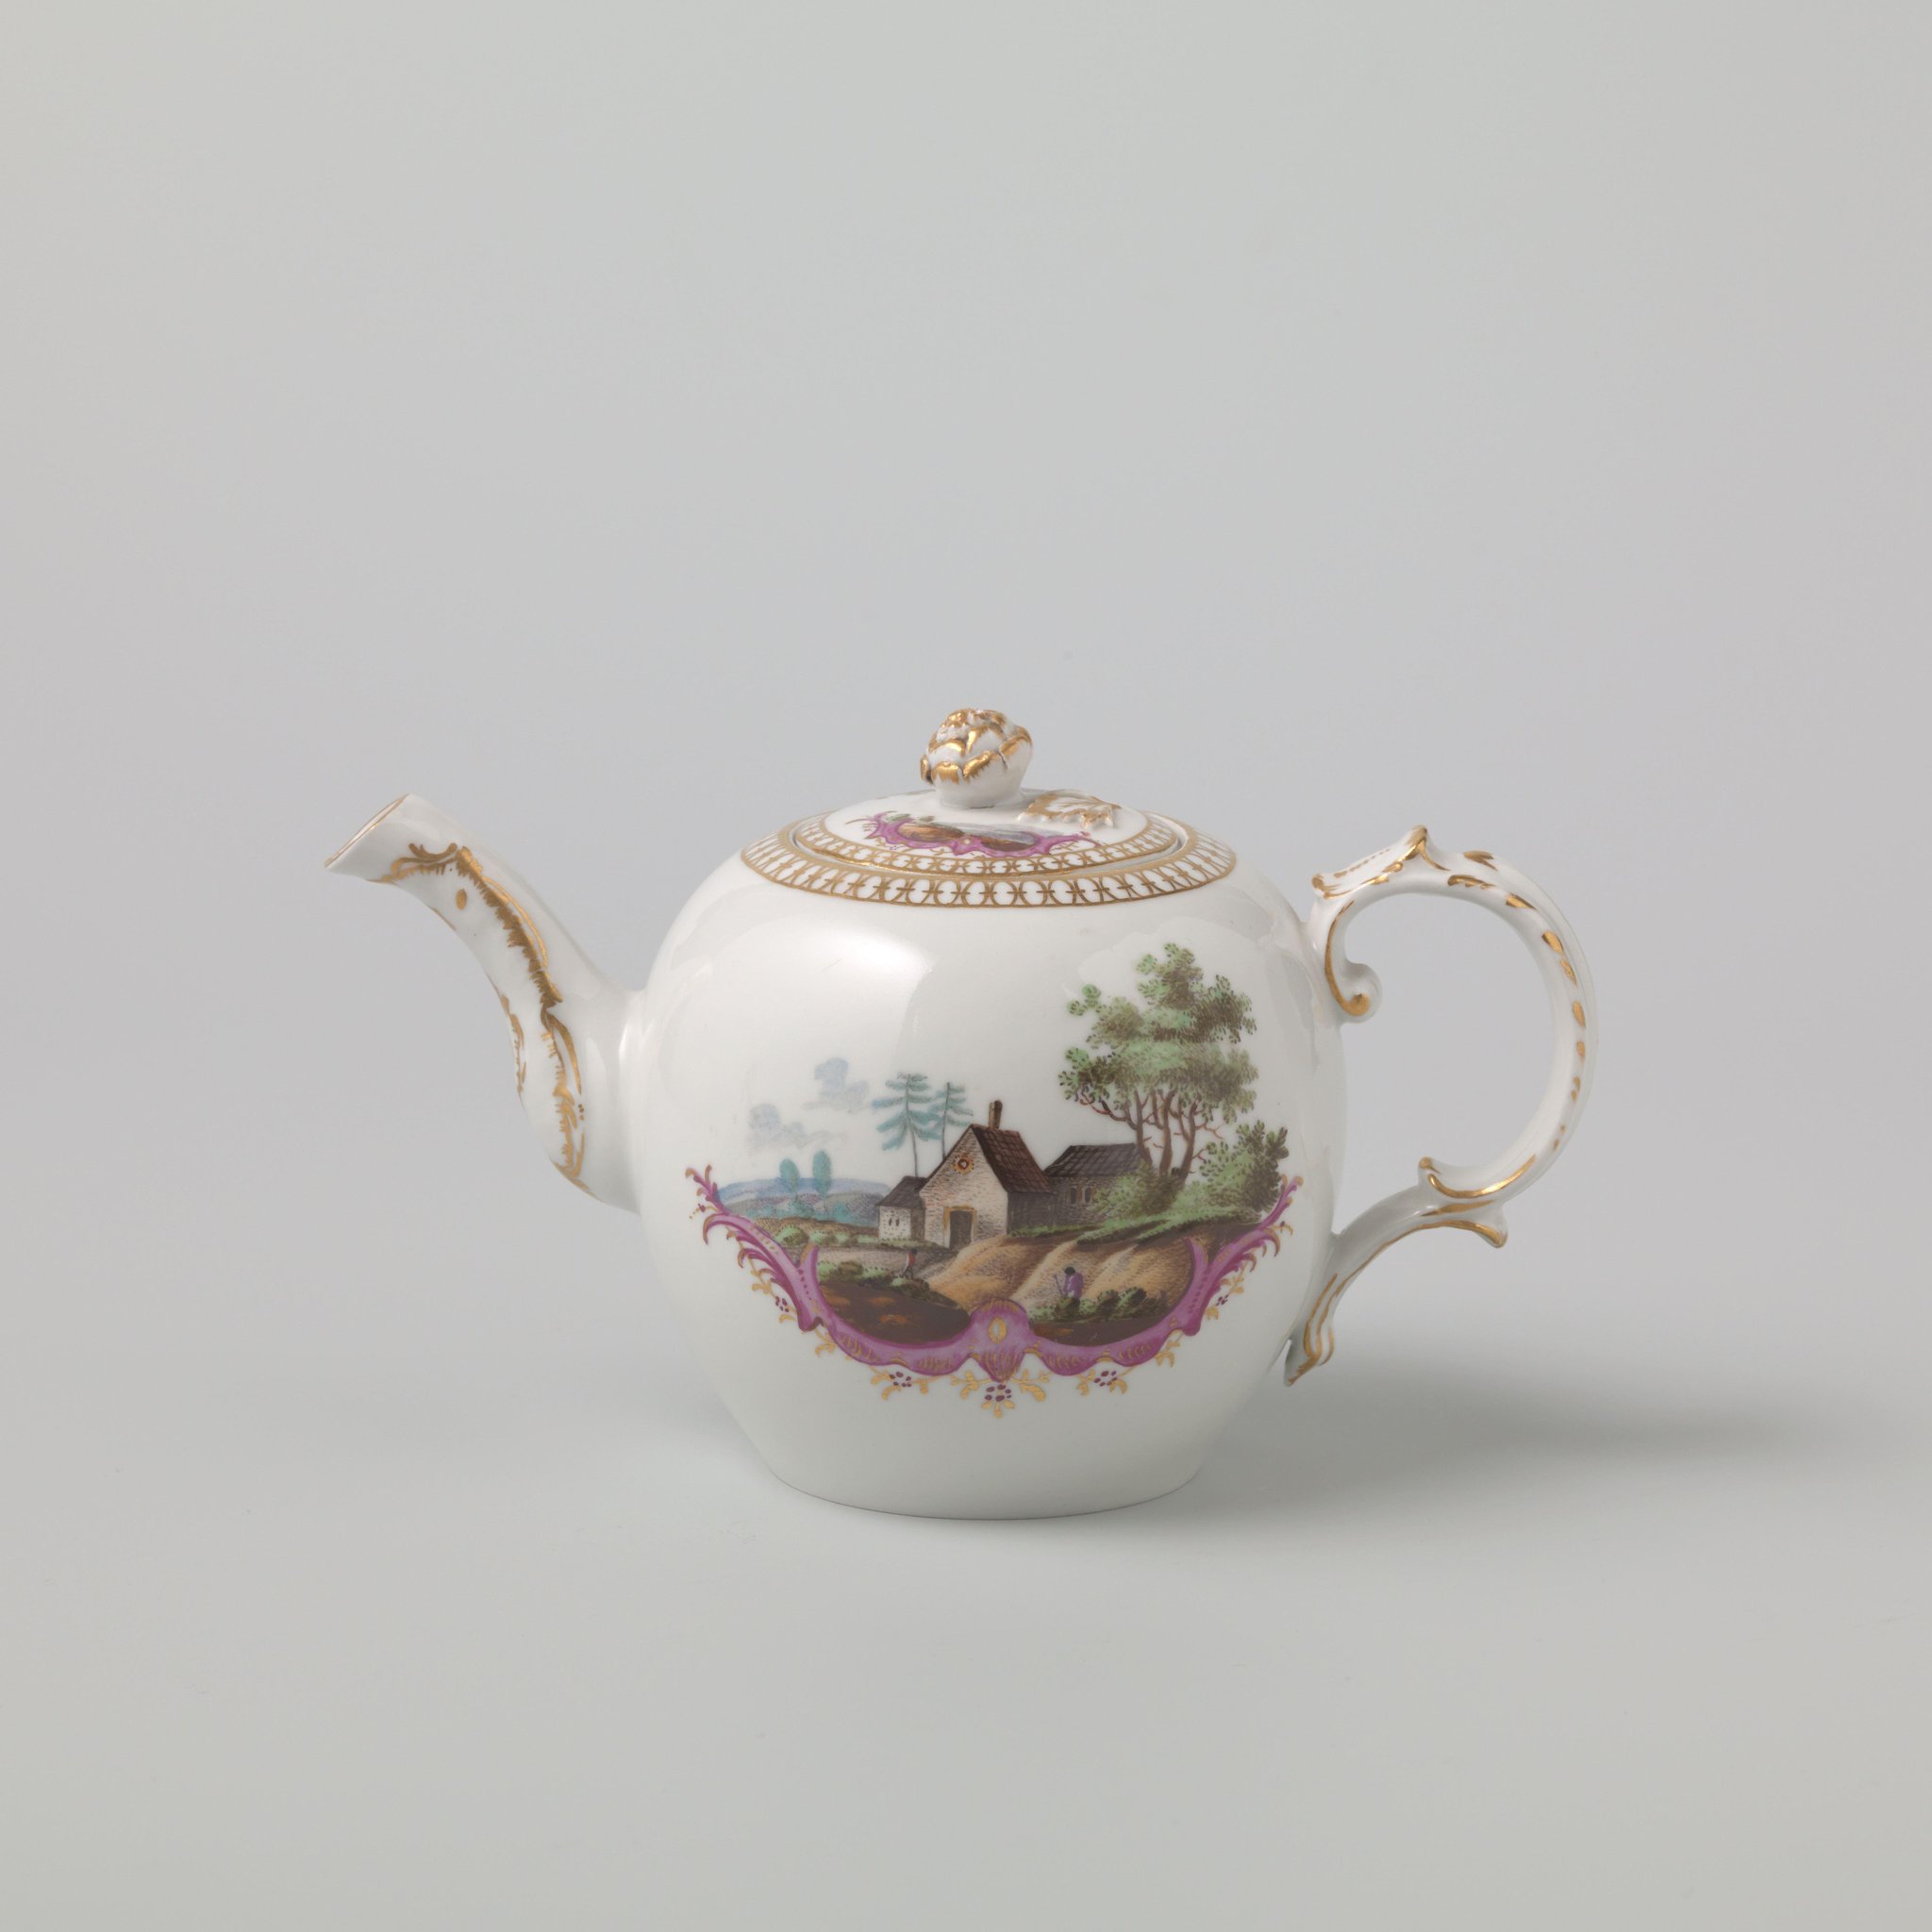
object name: teapot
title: Cover of a teapot with two landscapes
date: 1765-1775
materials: glaze, gold, paint, porcelain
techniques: firing, forming, gilding, turning, vitrification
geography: furstenberg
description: Deksel van een theepot van porselein, beschilderd op het glazuur in emailkleuren en goud. Versierd met tweemaal een landschap, waaronder een rocaille band. Op de rand een decoratieve band. Dekselknop in de vorm van een bloemtak.